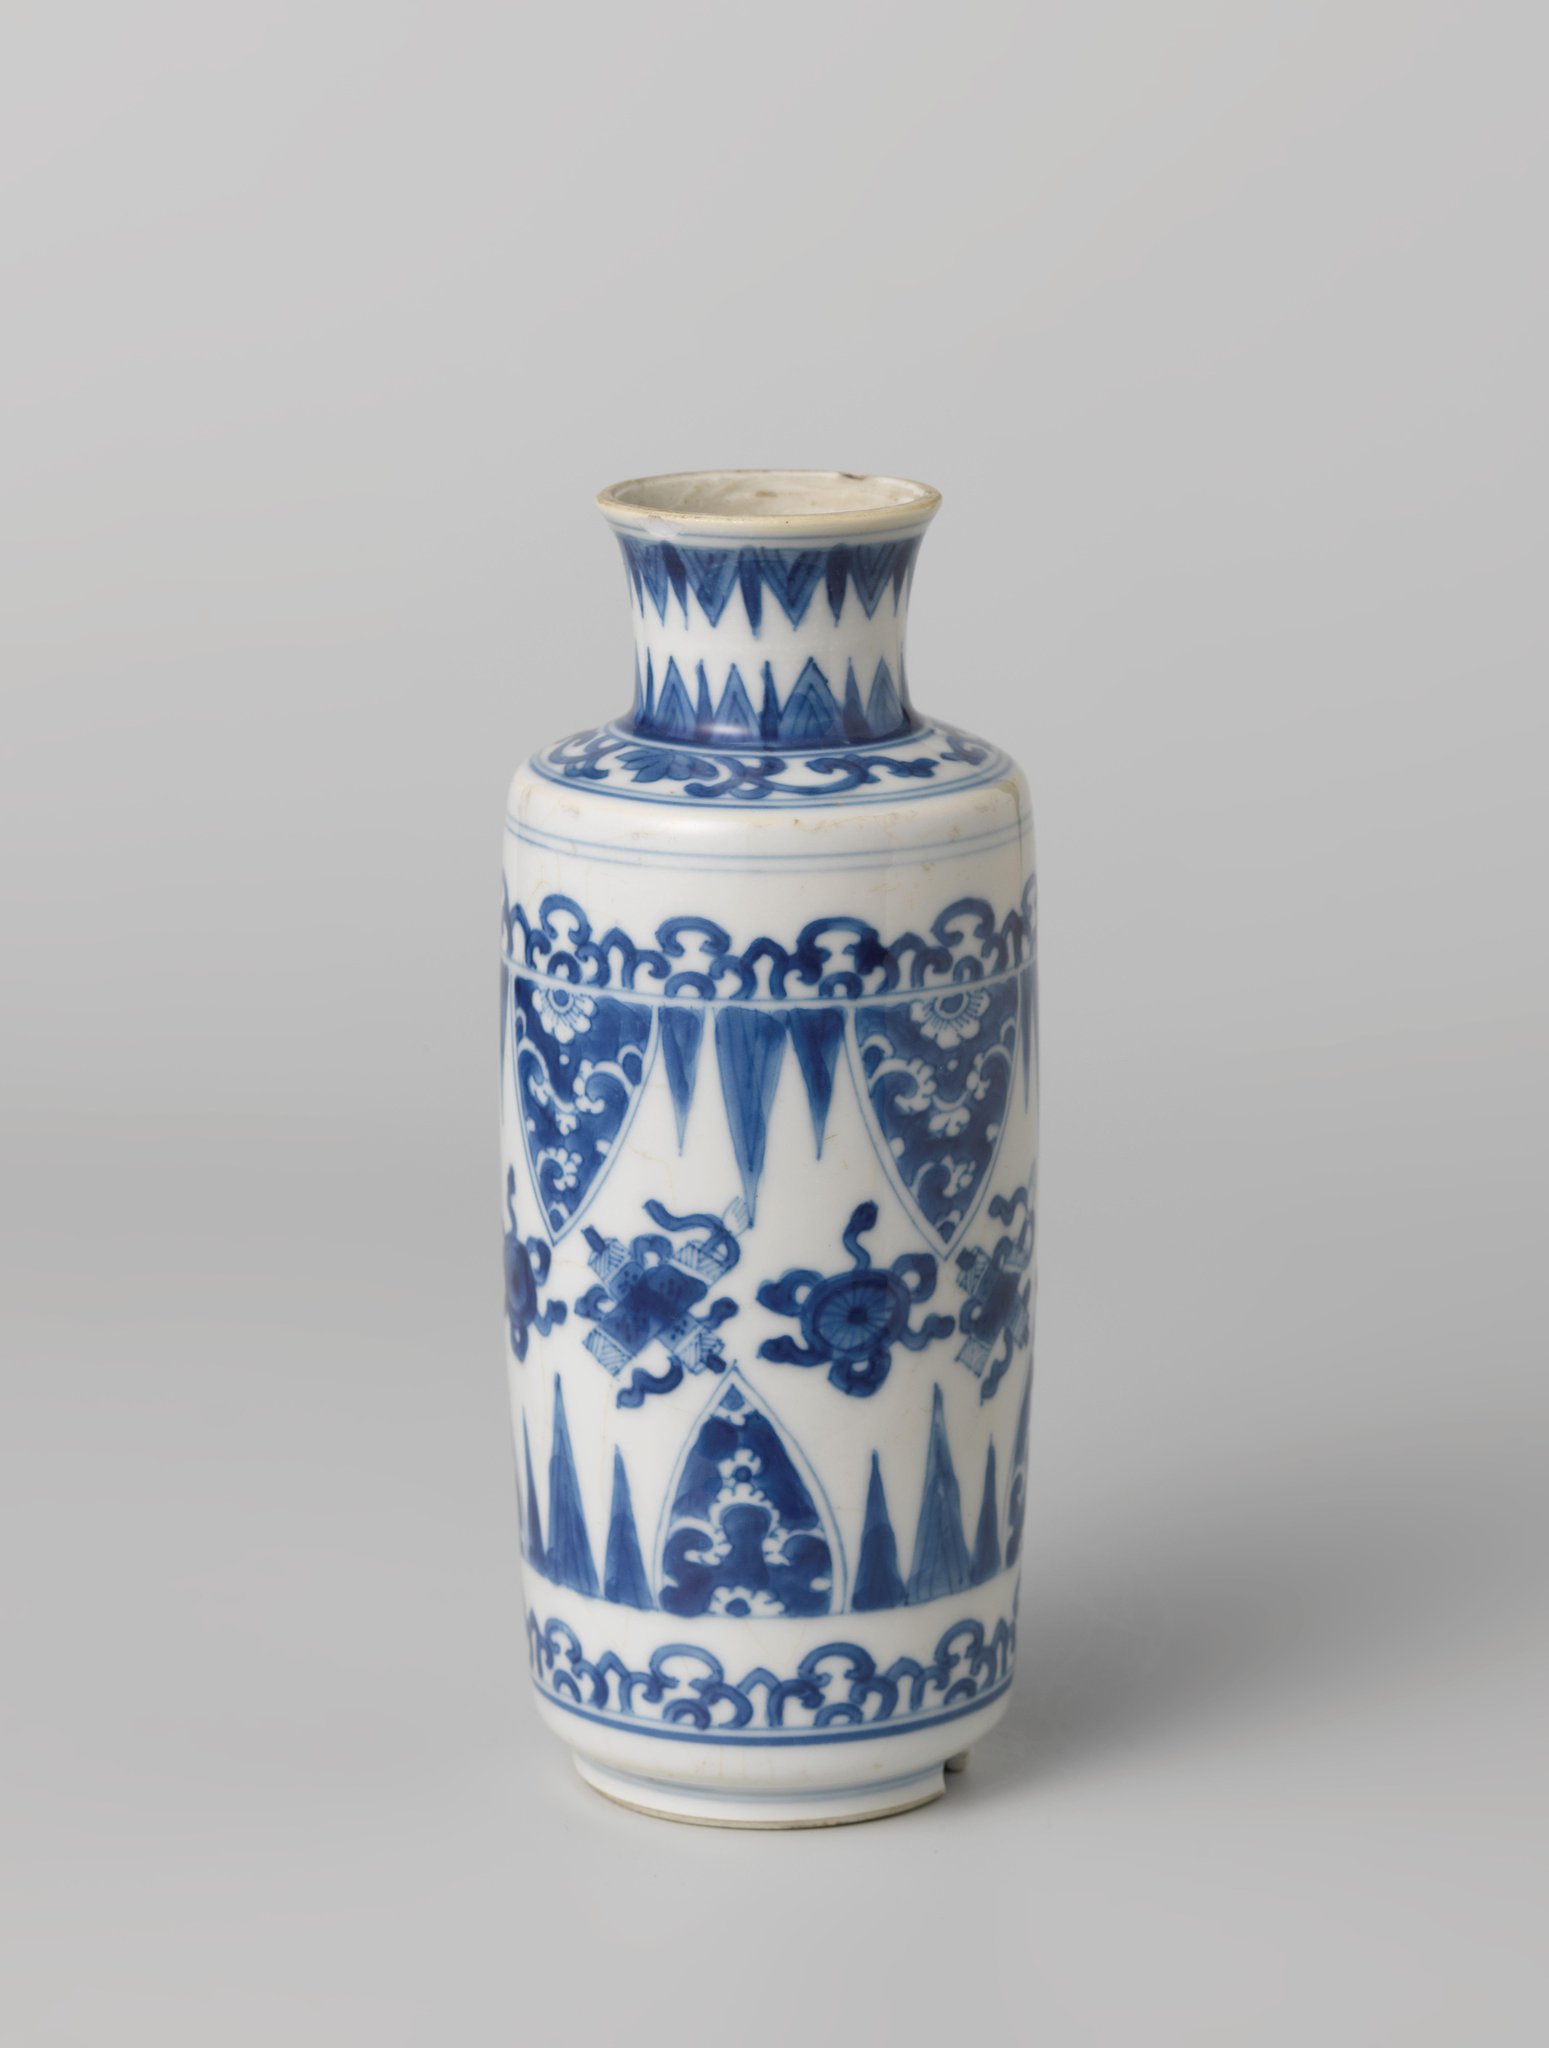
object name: bottle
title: Cilindrical bottle vase with auspicious symbols, scrolls and petal borders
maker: Anonymous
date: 1680-1720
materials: cobalt, glaze, paint, porcelain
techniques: firing, turning, vitrification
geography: china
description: AK-NM-6805 Vaas • Blauw-wit Kangxi-porselein • Lambrequin- of ruyi-ornament • Onderdeel van Royers porseleincollectie Deze vaas heeft, net als AK-NM-6800, de Kangxi-vorm van de rolwagen uit de Overgangsperiode. Ook de gestileerde bananenbladeren op de hals en op het lichaam, hier wel gereduceerd tot vrij levenloze driehoekjes, zijn elementen die voorkomen op de Overgangs-rolwagens. Het is boeiend om te zien hoe tussen die bananenbladeren op de buik grotere velden zijn geschilderd die doen denken aan de bekende lambrequin-banden zoals bijvoorbeeld op de dekselpot AK-NM-6778-A. Als we ervan uitgaan dat de decoratie van het porselein (ornamentaal, niet verhalend) zich ontwikkelde van de drukte en volte van het Kraakgoed naar de rust van wat Daniël Marot (1660-1752) op zijn schoorstenen tekende, dan is dit weer een boeiende tussenvorm. Die smalle bandjes boven en onder aan de buik kennen we al uit de Overgangsperiode [Ayers 2016, vol. I, nrs. 233-234]. Die houden we er nog even in, moeten ze gedacht hebben. Maar blijkbaar werd er ook al gewezen naar die proto-lambrequins. Dat vinden we mooi. Doe dat er maar bij. En als de leegte je toch wat beangstigt, kun je er altijd nog wat gelukssymbolen tussen schilderen. Vraag en aanbod kunnen mijns inziens niet anders dan tastenderwijs bij elkaar gekomen zijn. Bronnen: John Ayers, Chinese and Japanese works of art in the collection of Her Majesty The Queen, Londen, 2016.